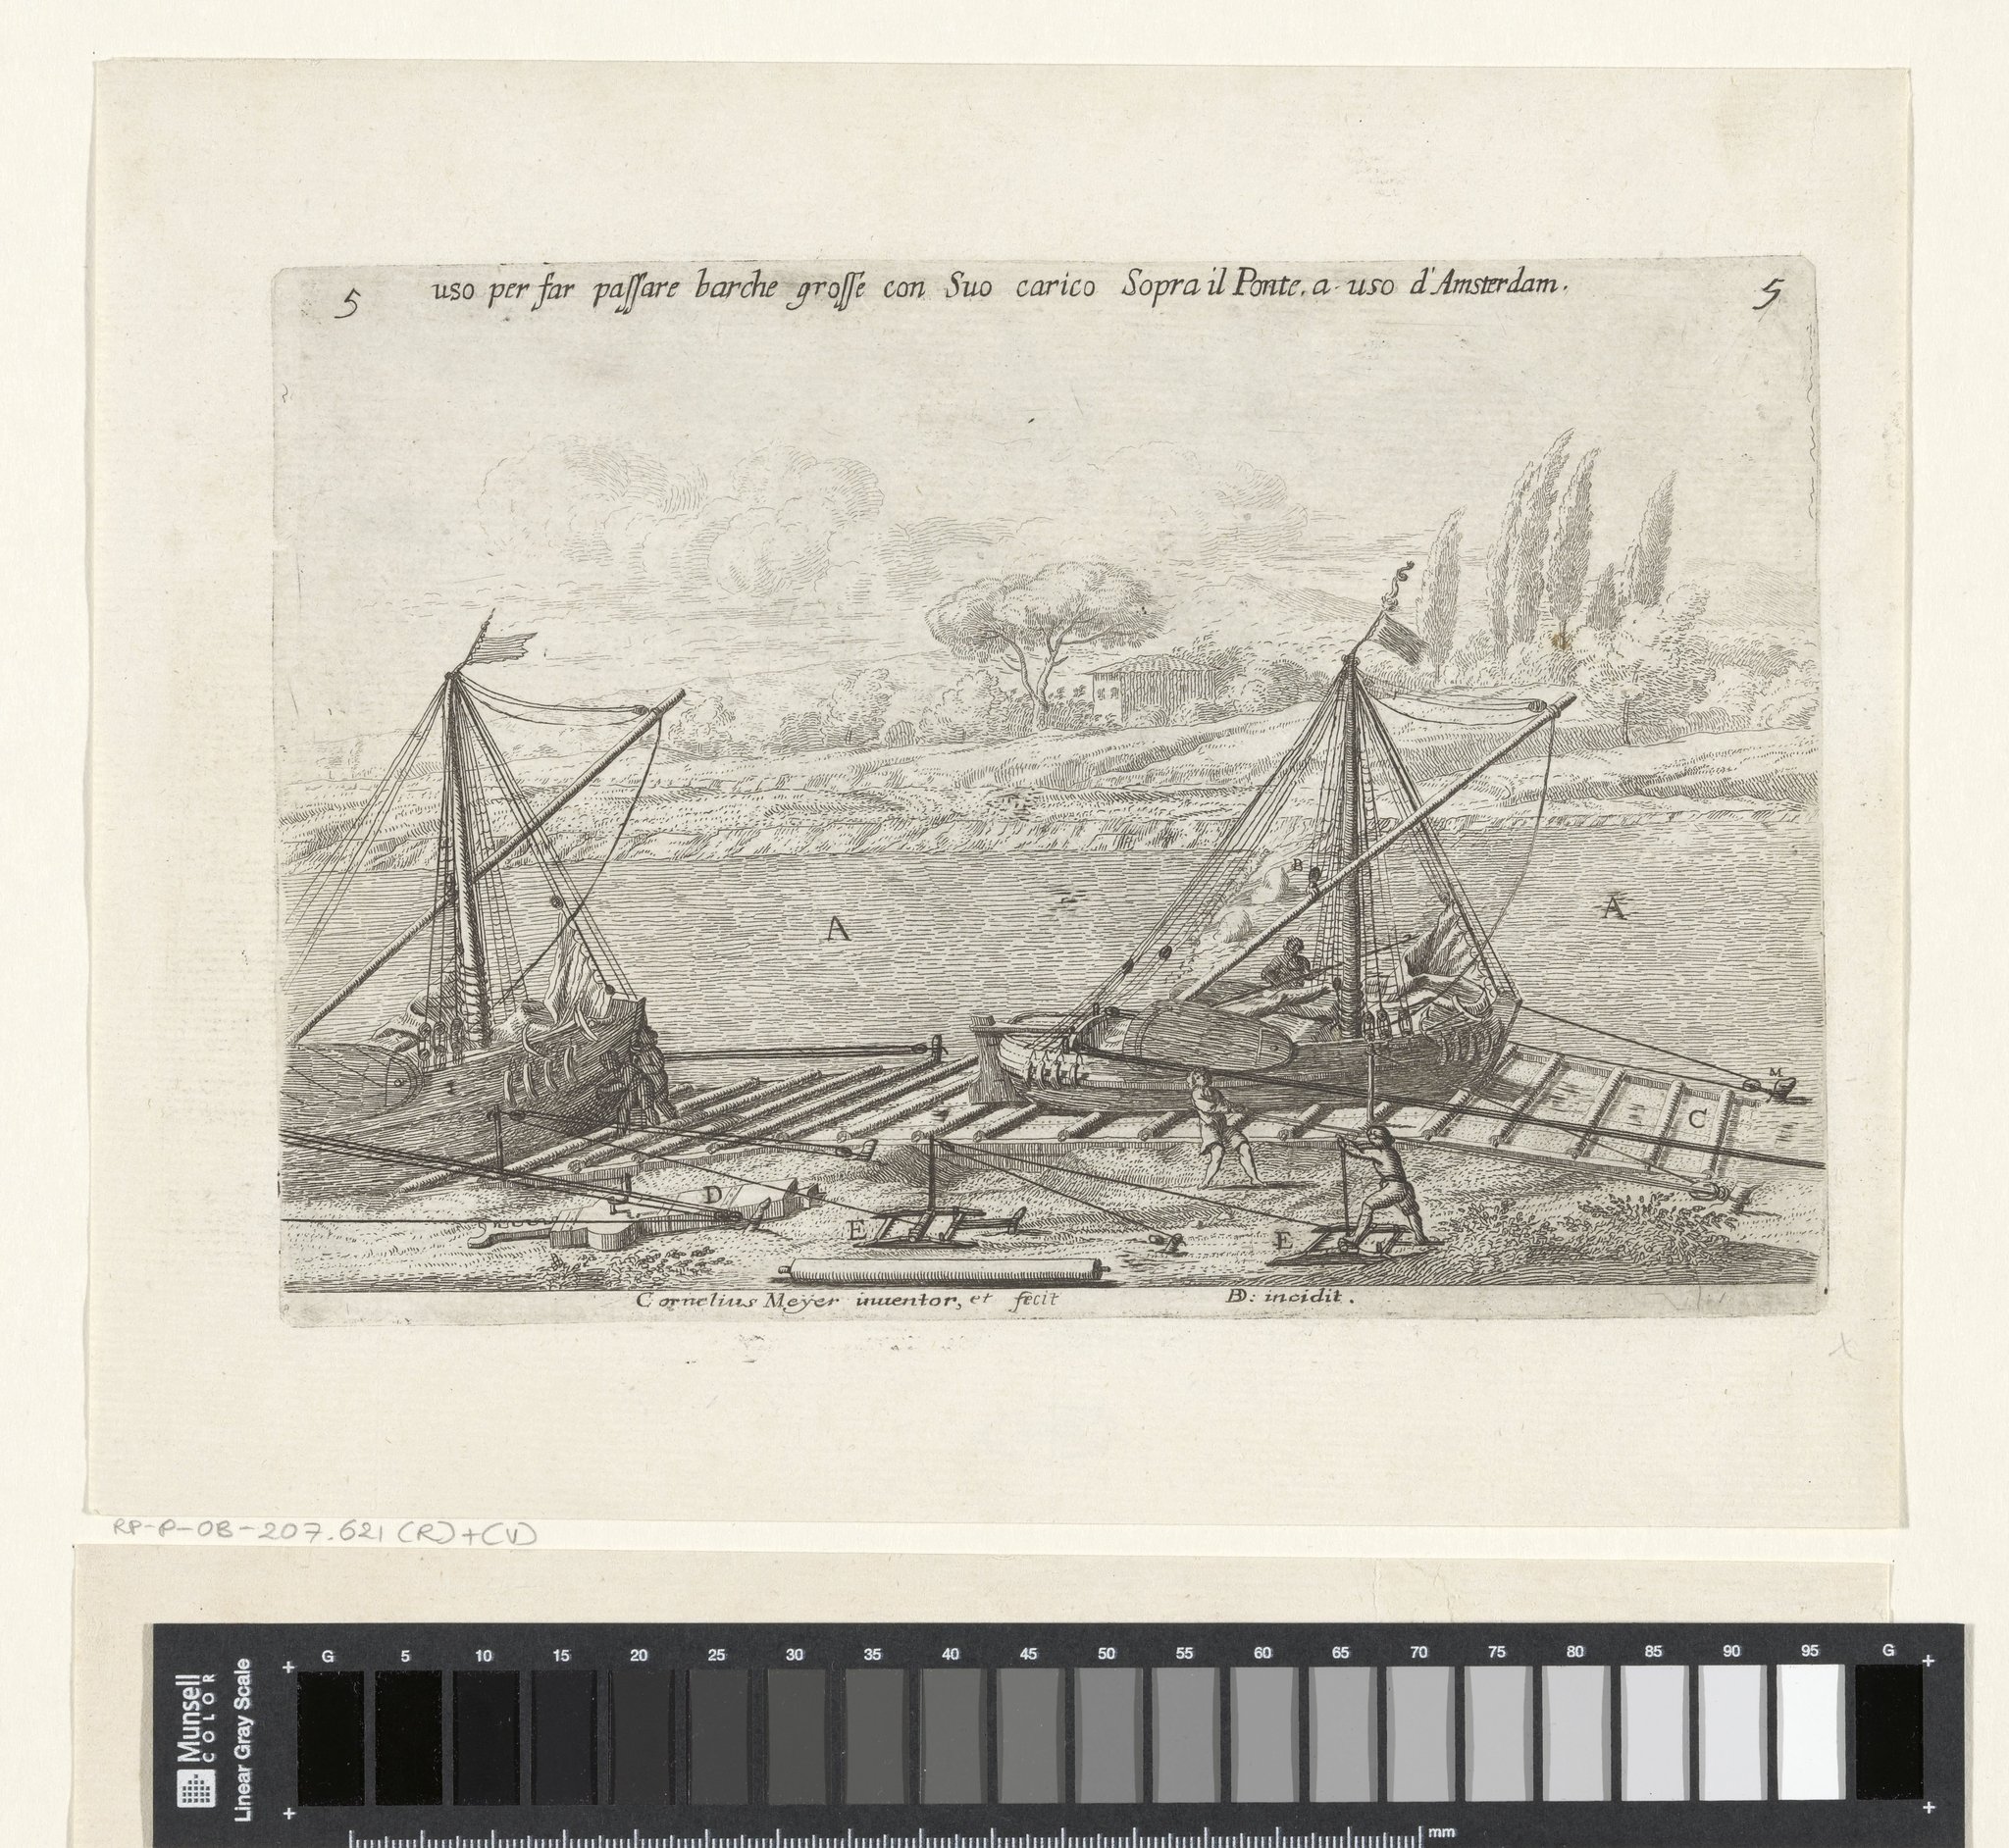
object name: print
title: L'arte di rendere i fiumi navigabili, in varij modi, con altre nuove inventioni, e varij altri segreti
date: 1677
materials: paper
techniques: etching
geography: rome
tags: river, ships (in general), rolling bridge (dutch: 'overtoom')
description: Deze prent maakte oorspronkelijk deel uit van een publicatie bestaande uit drie delen, uitgegeven door G.G. Komarek in Rome in 1696. Het eerste deel zit achter een titelpagina met de titel: L'arte di rendere i fiumi navigabili, in varij modi, con altre nuove inventioni, e varij altri segreti. Deel twee zit achter een titelpagina met de titel: Racolta di varii segreti come si vedono nelle segventi figure. Deel drie zit achter een titelpagina met de titel: Osservazioni delle comete che dovranno seguire, e dell'ecclisse del primo satellite di Giove, et altre propositioni prosicue da farsi per commodo & ornamento della città. Deze prent komt uit het eerste deel. Prenten in de publicatie zijn naar ontwerp van Cornelis Meijer gemaakt door verschillende prentmakers, onder wie G.B. Falda, G. van Wittel, Gomar Wouters, etc. Er is ook een eerdere versie bekend van deze publicatie, uitgegeven in Rome in 1683, met de titel: L'arte di restituire a Roma la tralasciata navigazione del suo Tevere.